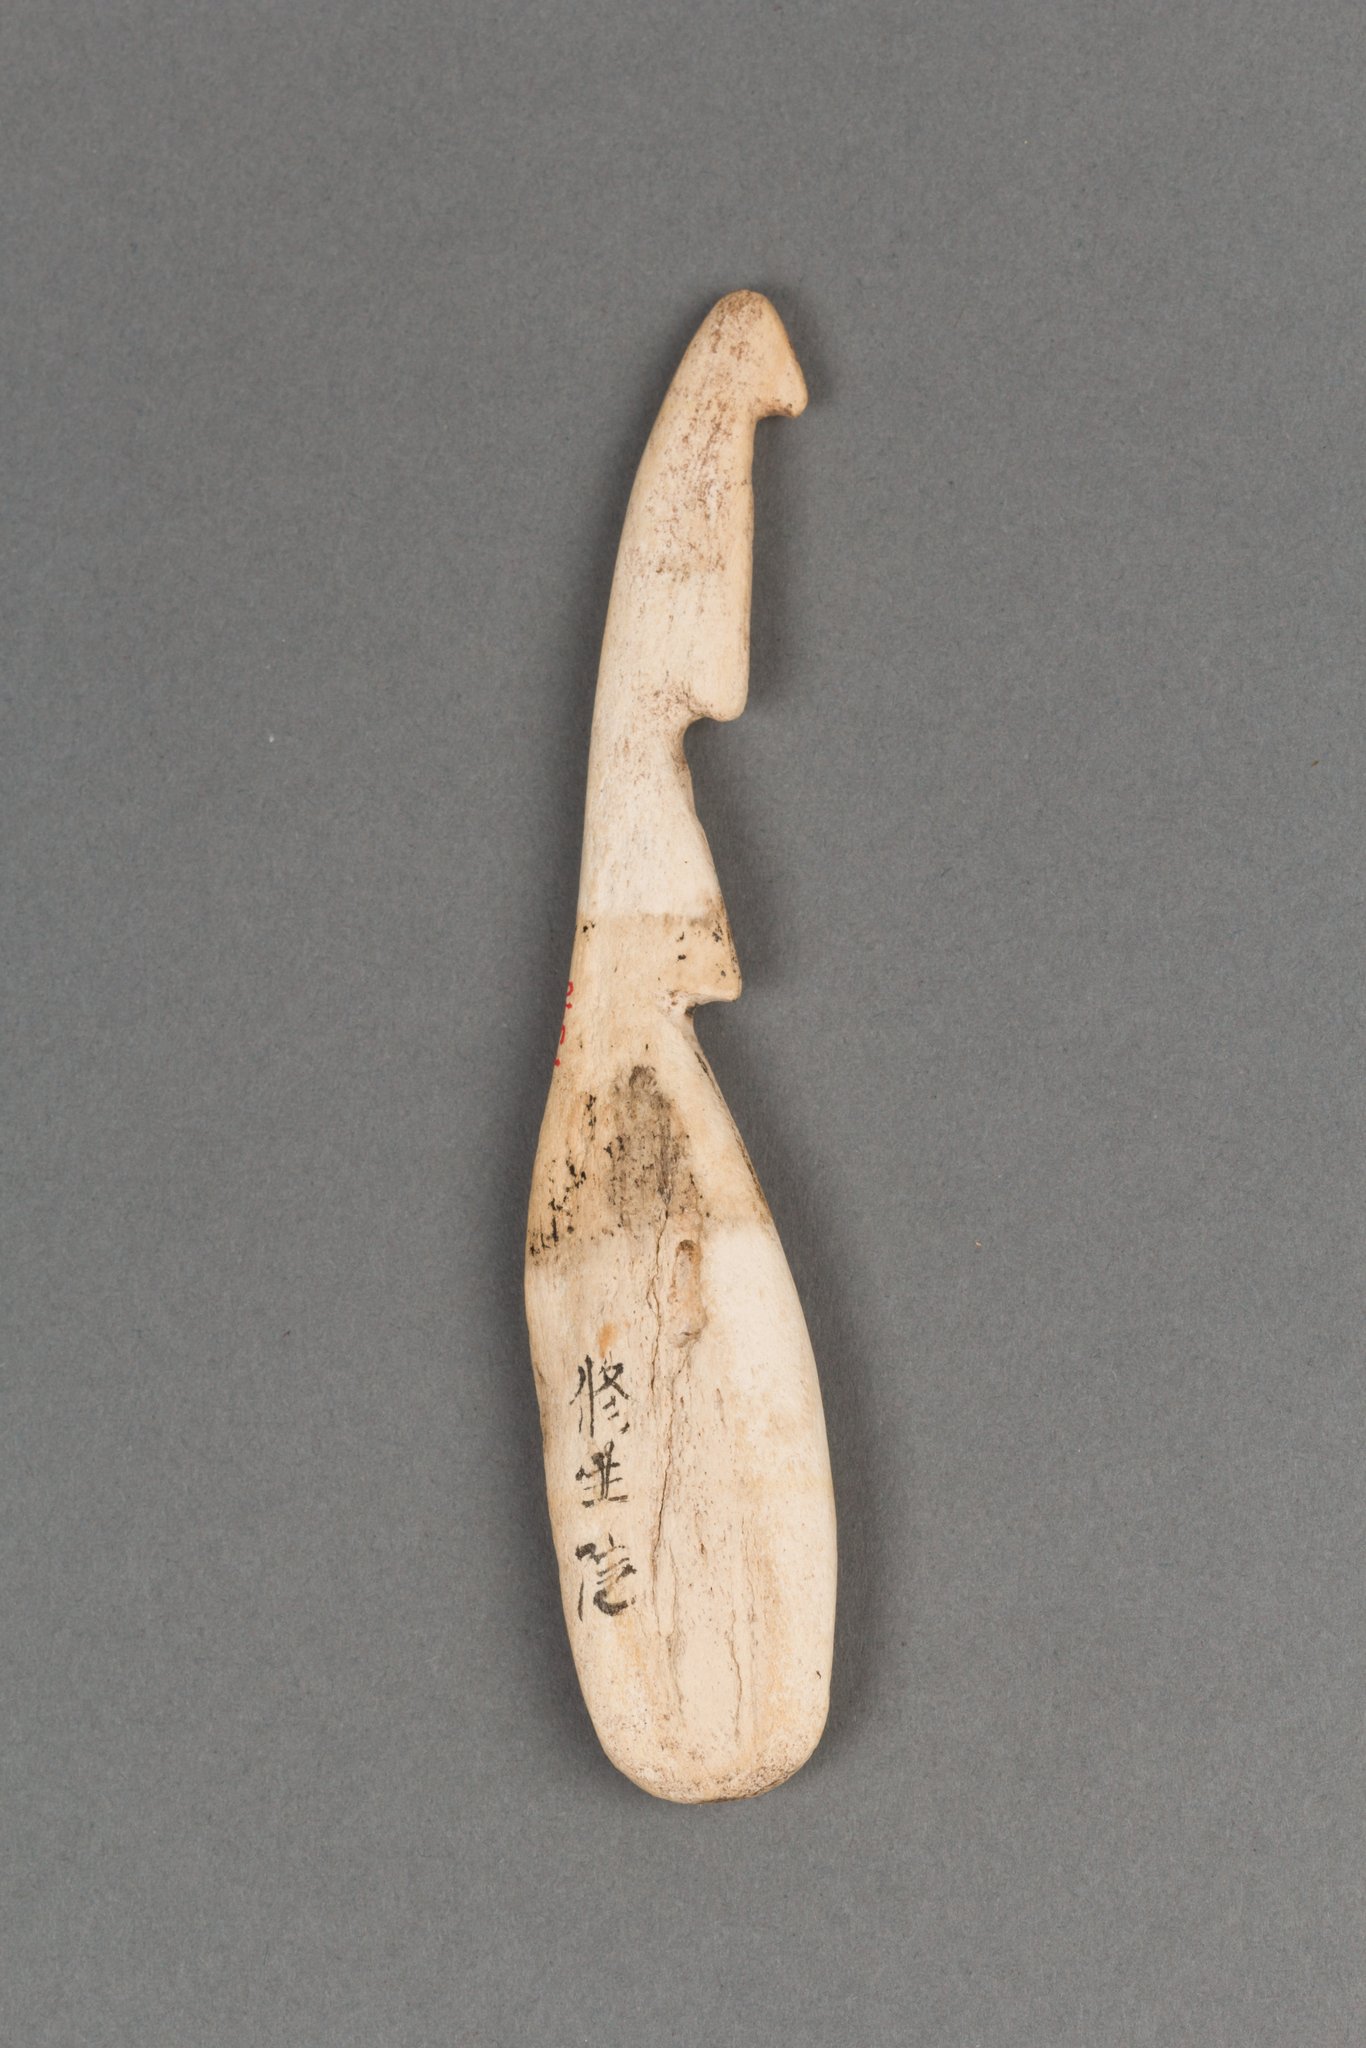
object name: harpoon head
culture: japanese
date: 1200-200 BCE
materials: bone